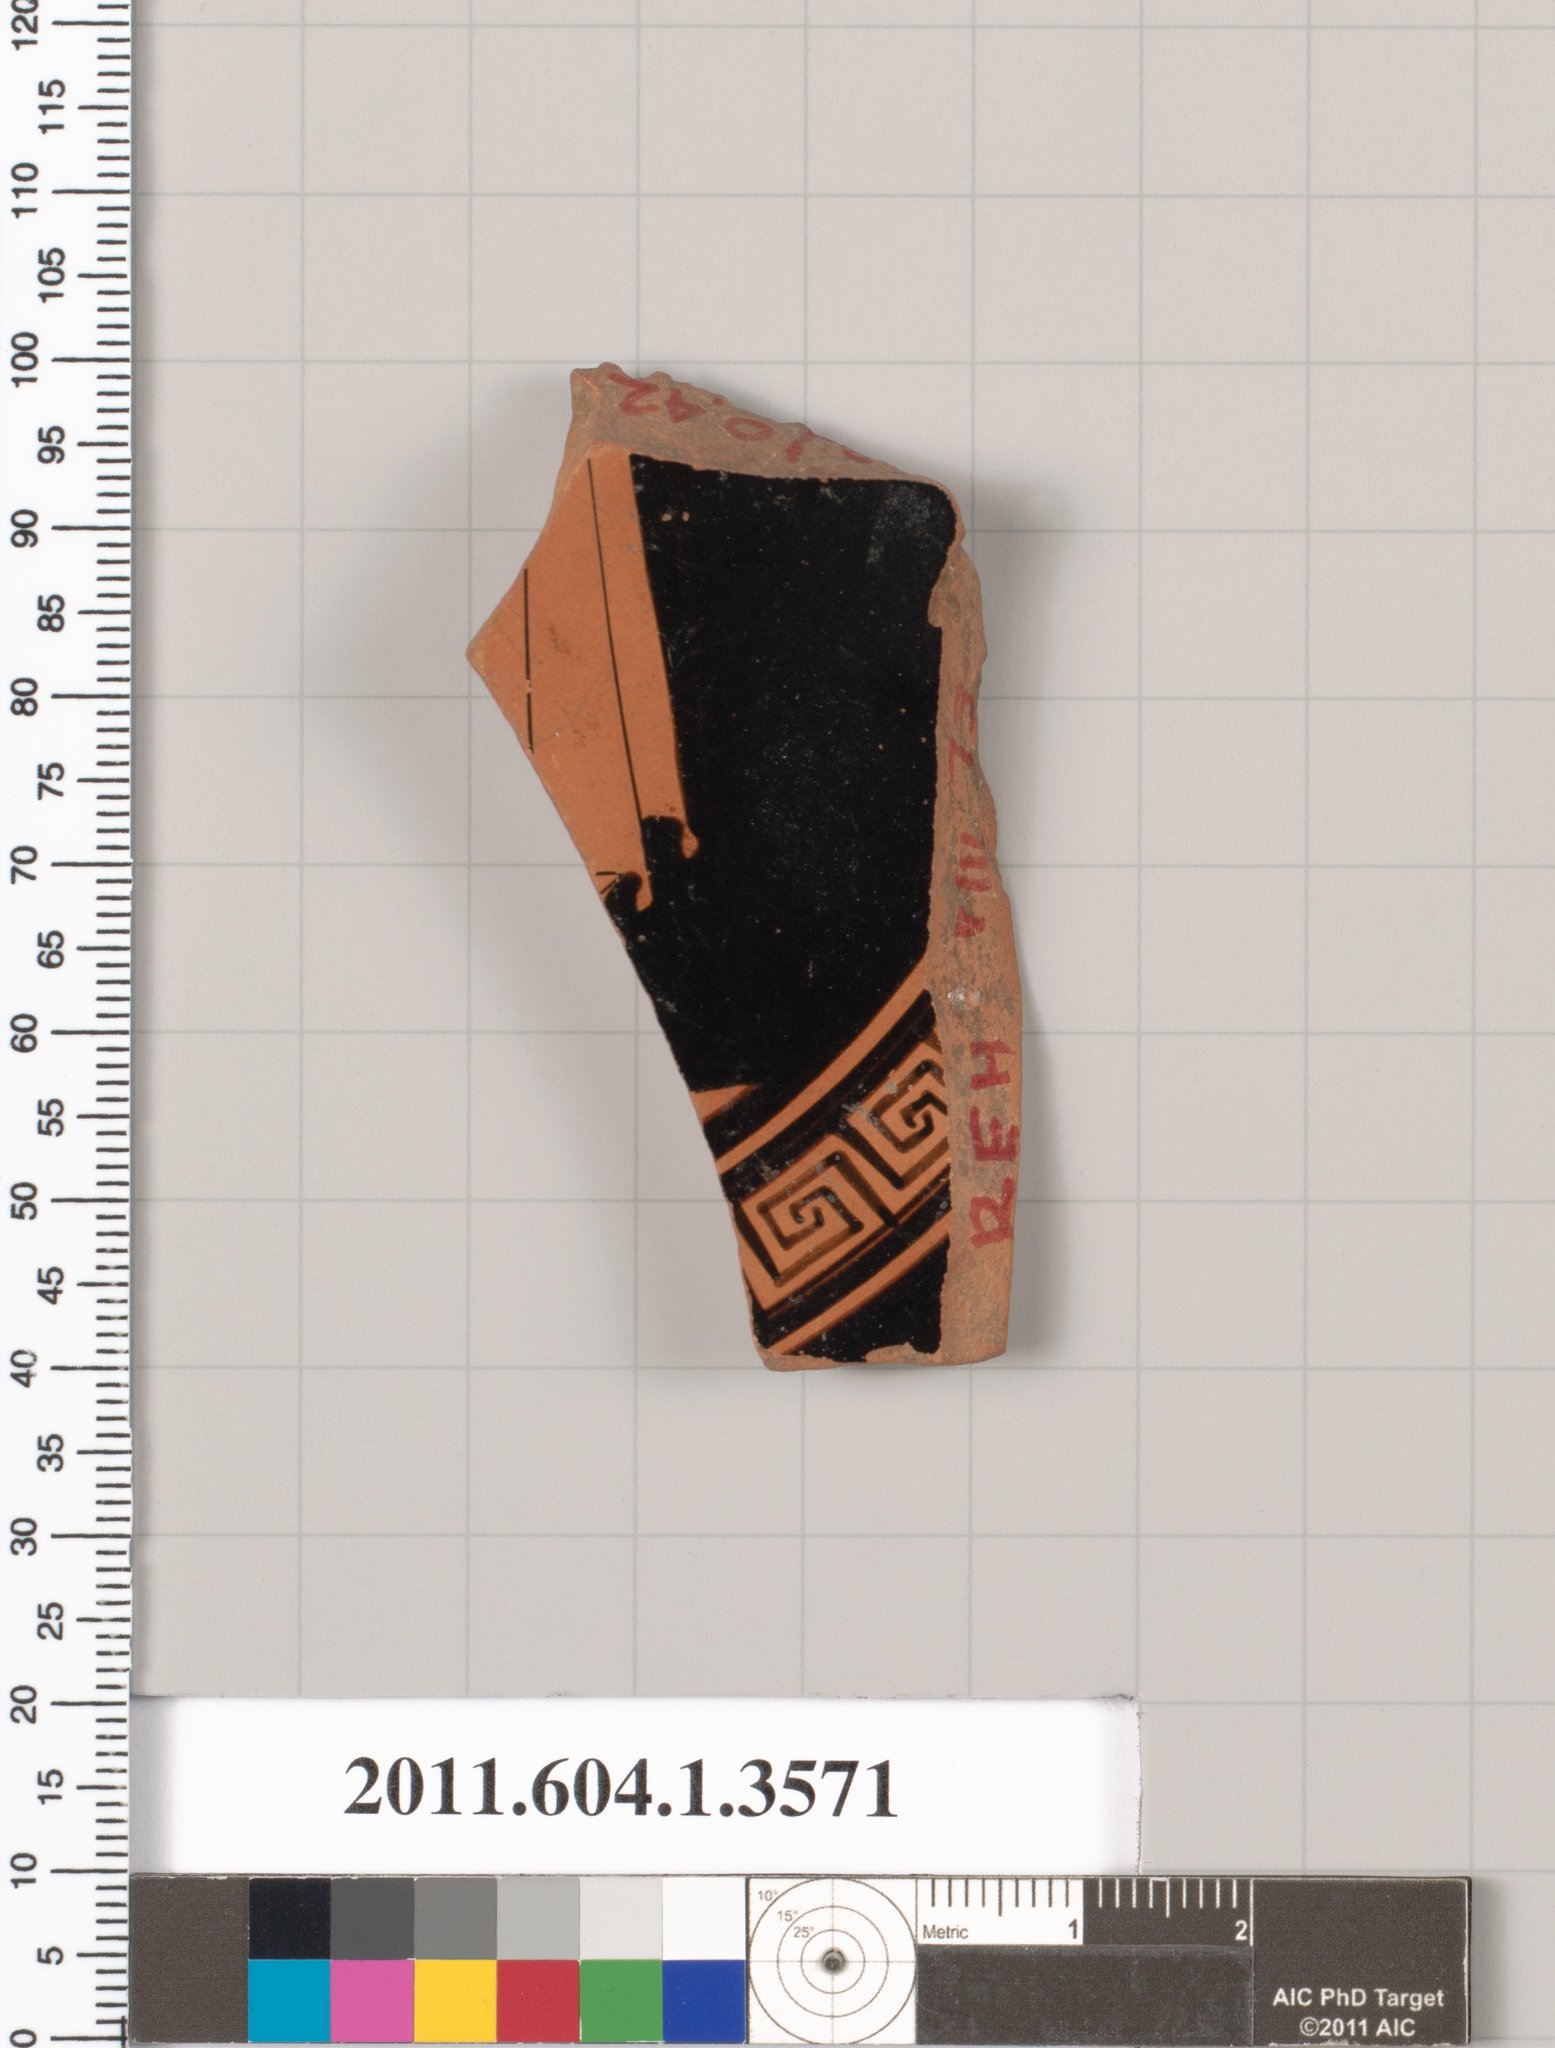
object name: kylix fragment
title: Terracotta fragment of a kylix (drinking cup)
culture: greek, attic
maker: lyandros painter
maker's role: artist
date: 480-470 BCE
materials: terracotta